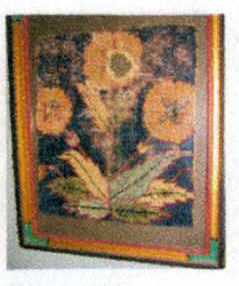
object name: carpet fragment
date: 1501-1600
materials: wool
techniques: asymmetrically knotted pile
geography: northern india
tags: flowers